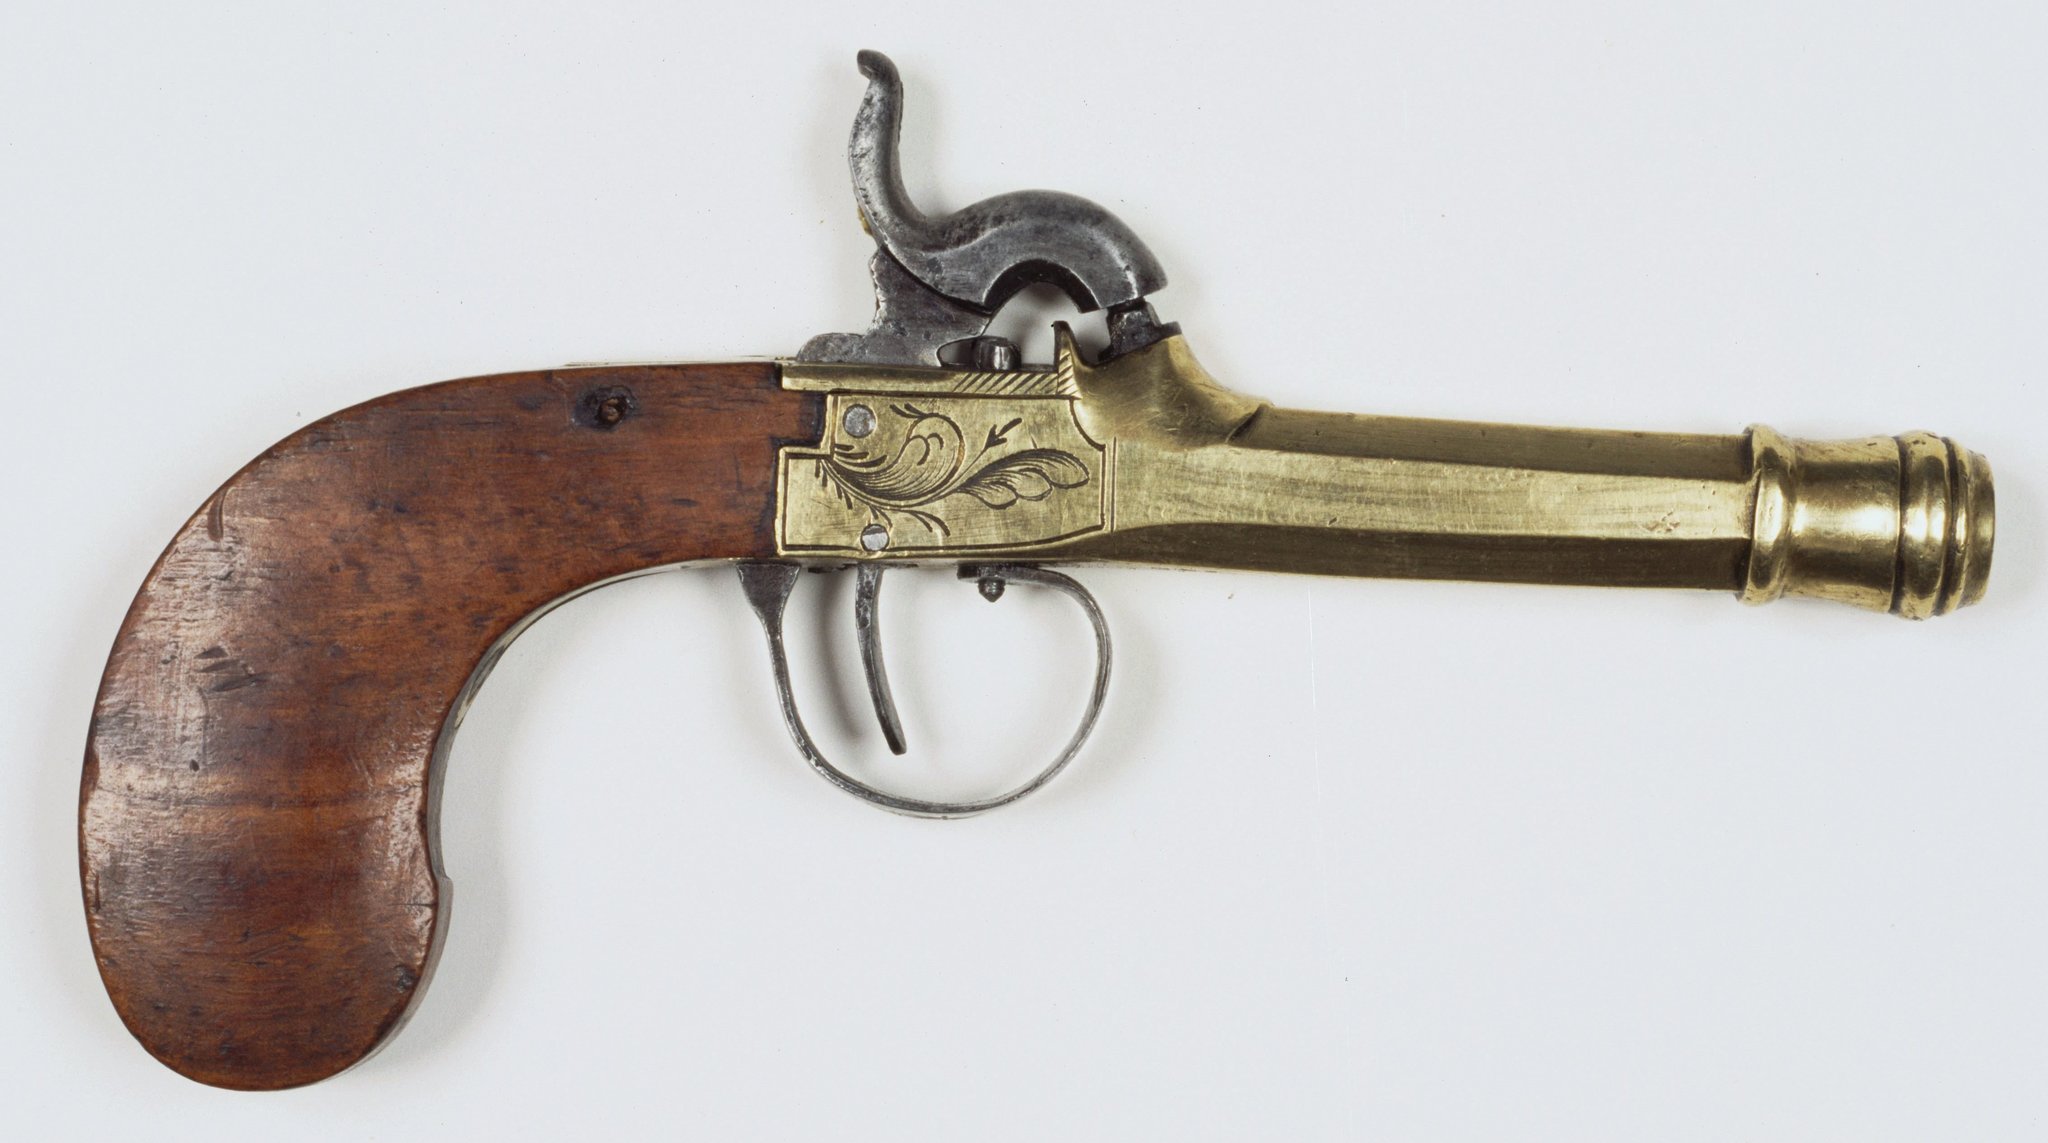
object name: pocket pistol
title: Zakpistool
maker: Anonymous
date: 1814-1866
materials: brass, iron, wood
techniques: engraving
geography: liège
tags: netherlands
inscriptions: mark: ‘ELG’, number: ‘430’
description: Zakpistool, percussiepistool met loop en slotplaat van messing, ijzeren haan, trekker en beugel en houten kolf. De loop is achthoekig en van binnen getrokken. De slotplaat heeft heeft enig lofwerk aan beide zijden. De kolf is gemaakt van hout en zit met een twee ijzeren pinnen bevestigd aan de slotplaat. Onderaan de slotplaat staat het nummer '430', 'NF' en een ovaal met daarin 'ELG'.